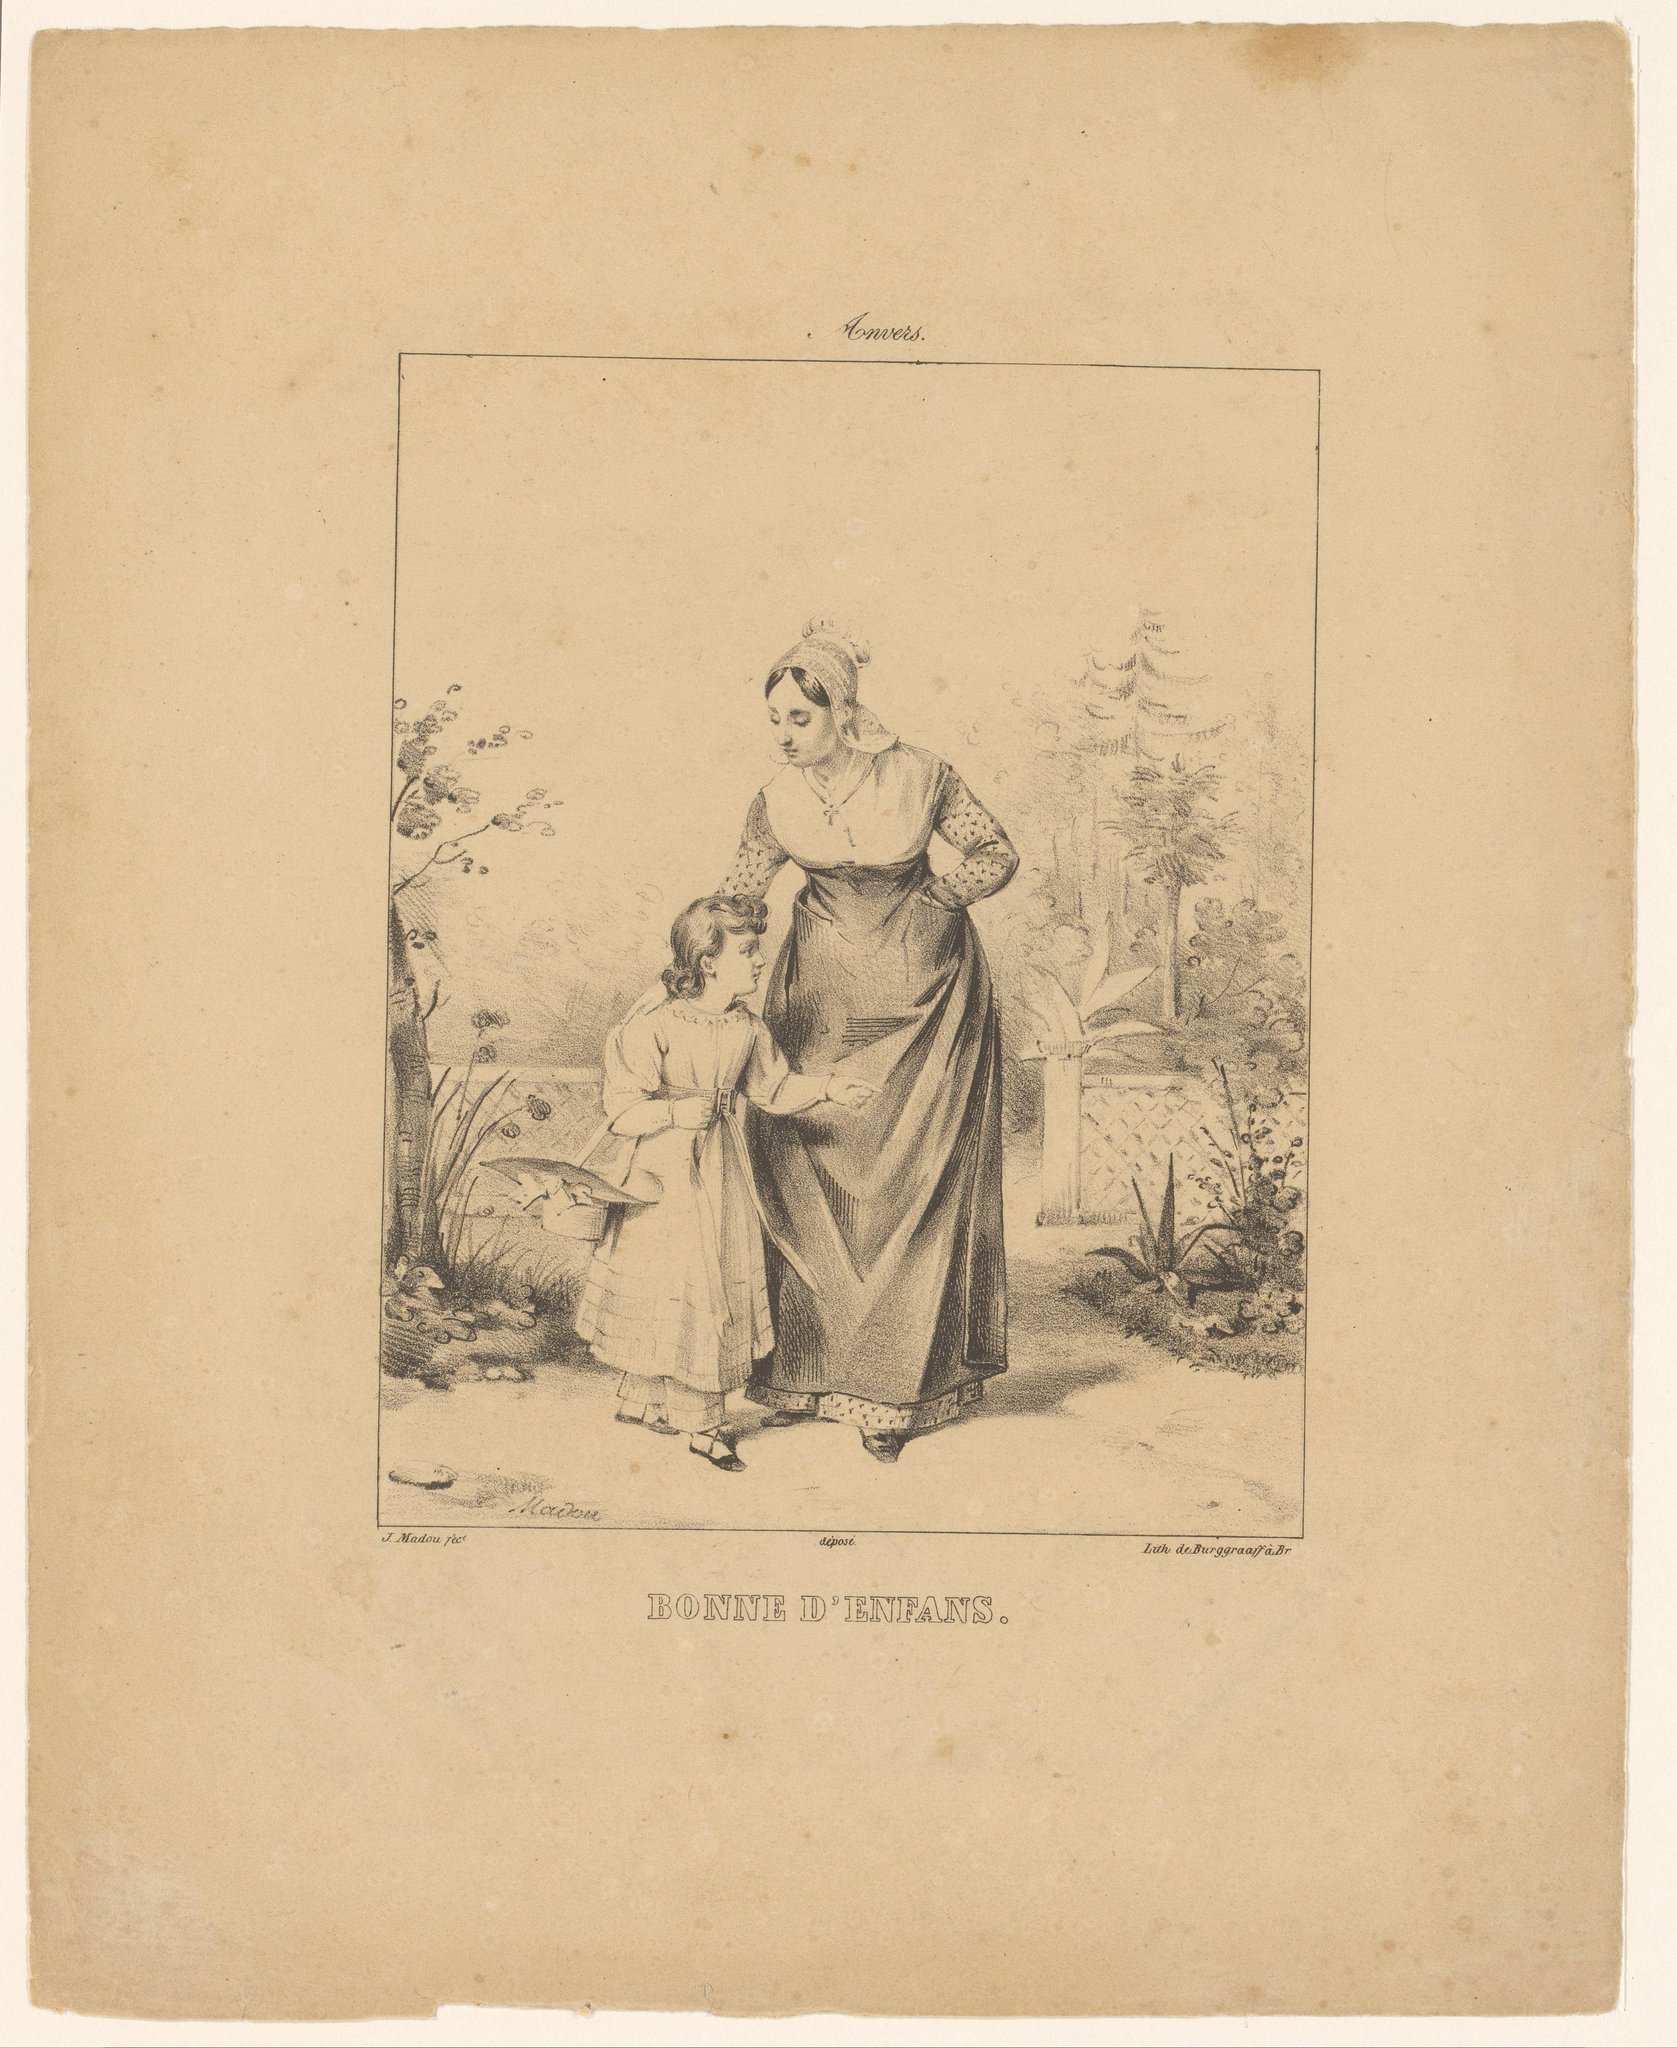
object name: print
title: Kostuums van de inwoners van Nederland en België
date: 1825-1835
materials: paper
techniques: lithograph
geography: brussels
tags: park, child, folk costume, regional costume, antwerp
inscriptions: : ‘Déposé’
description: Van den Burggraaff wilde een serie (twintig afleveringen met telkens vier platen) uitgeven met kostuums uit alle provincies van Nederland en België onder de titel 'Costumes du peuple de toutes les provinces des Pays-Bas'. Hij begint met deze serie in 1825 en eindigt hiermee bij de dertiende aflevering in 1830. Omdat in 1830 België zicht afsplitst van Nederland geeft hij de prenten daarna apart uit onder de titels 'Costumes de peuple Hollandais' en 'Collection de costumes du peuple des provinces de la Belgique' (1835).